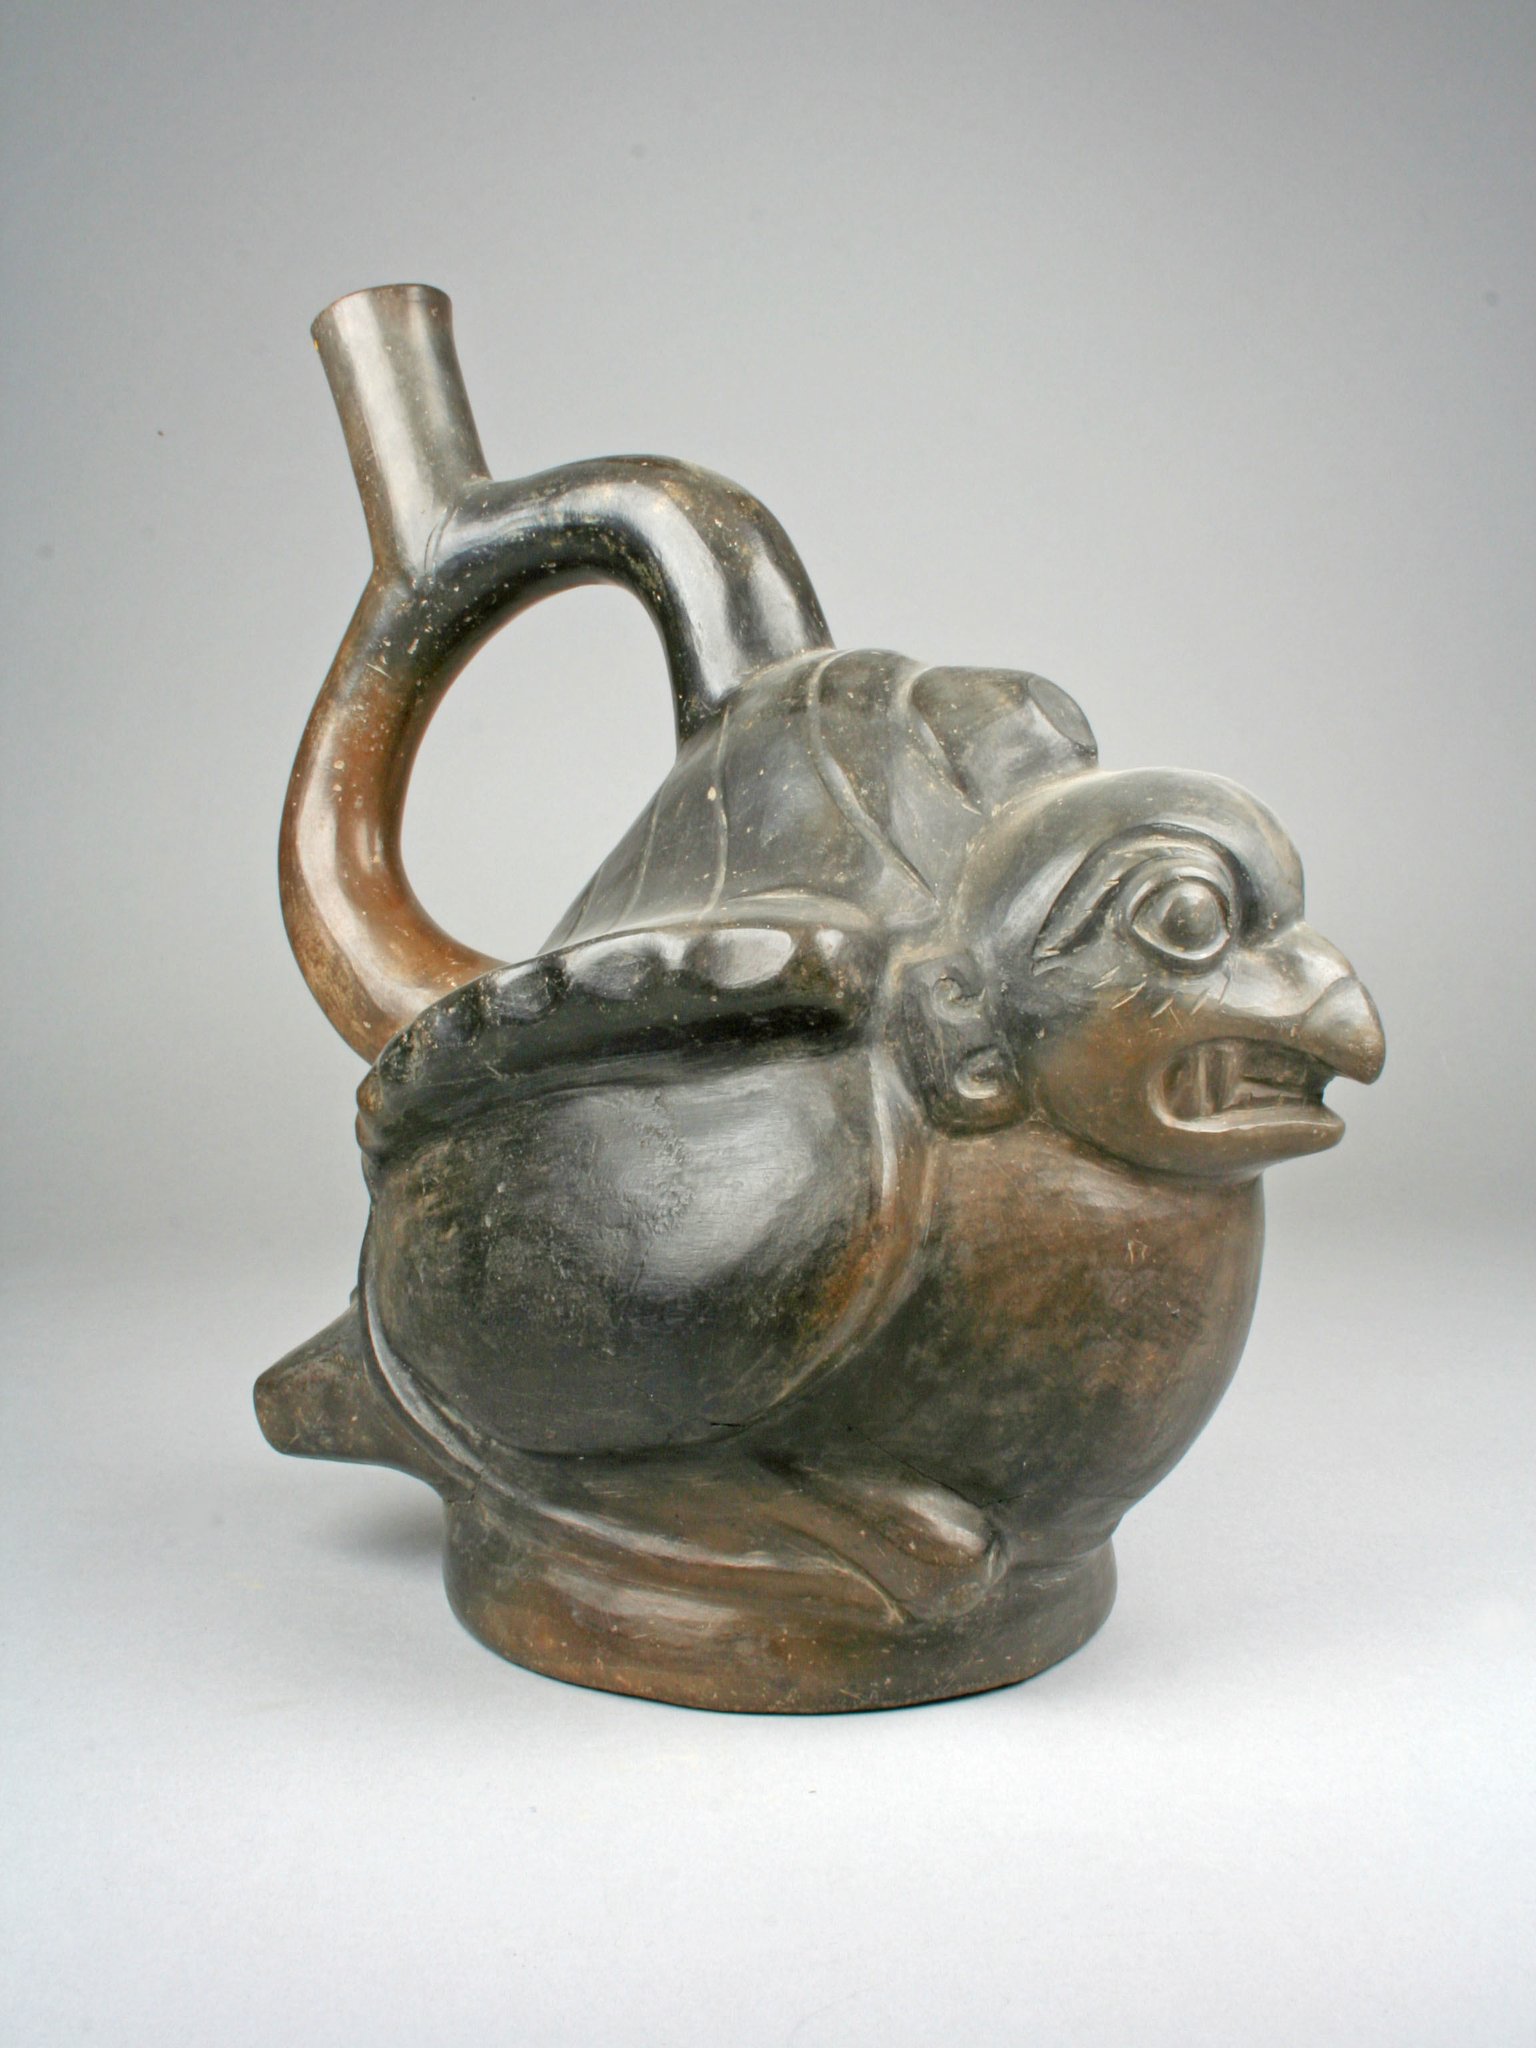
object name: bottle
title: Stirrup Spout Bottle with Bird and Snake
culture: moche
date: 401-700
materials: ceramic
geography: peru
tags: birds,snakes